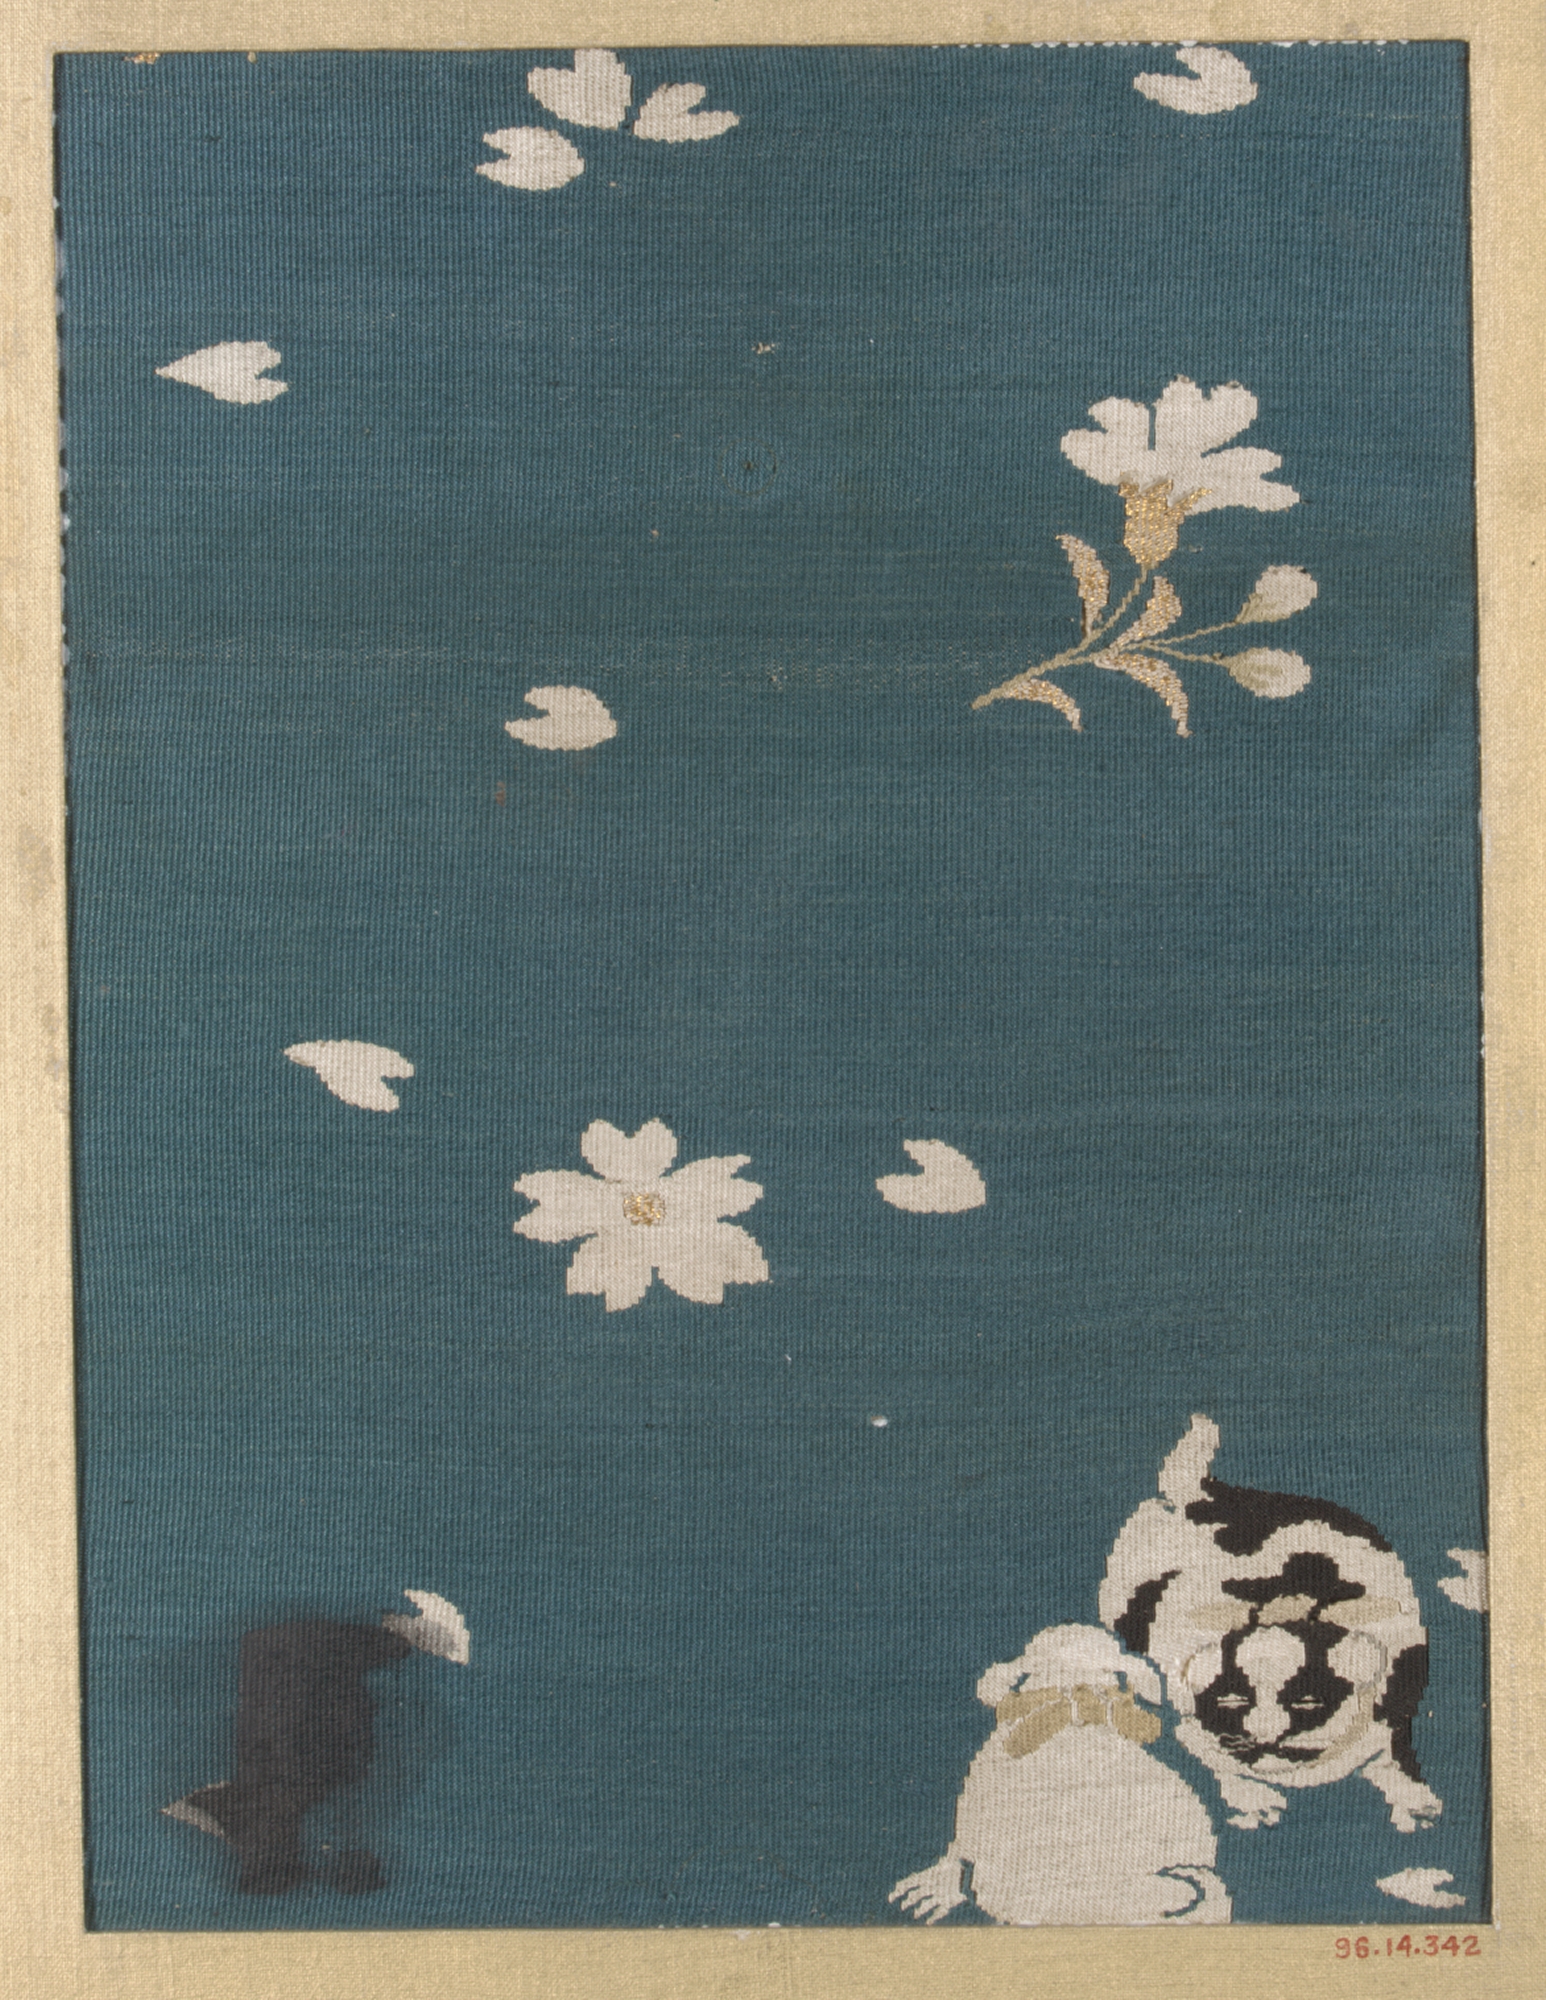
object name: piece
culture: japanese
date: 1701-1900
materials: silk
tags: flowers,leaves